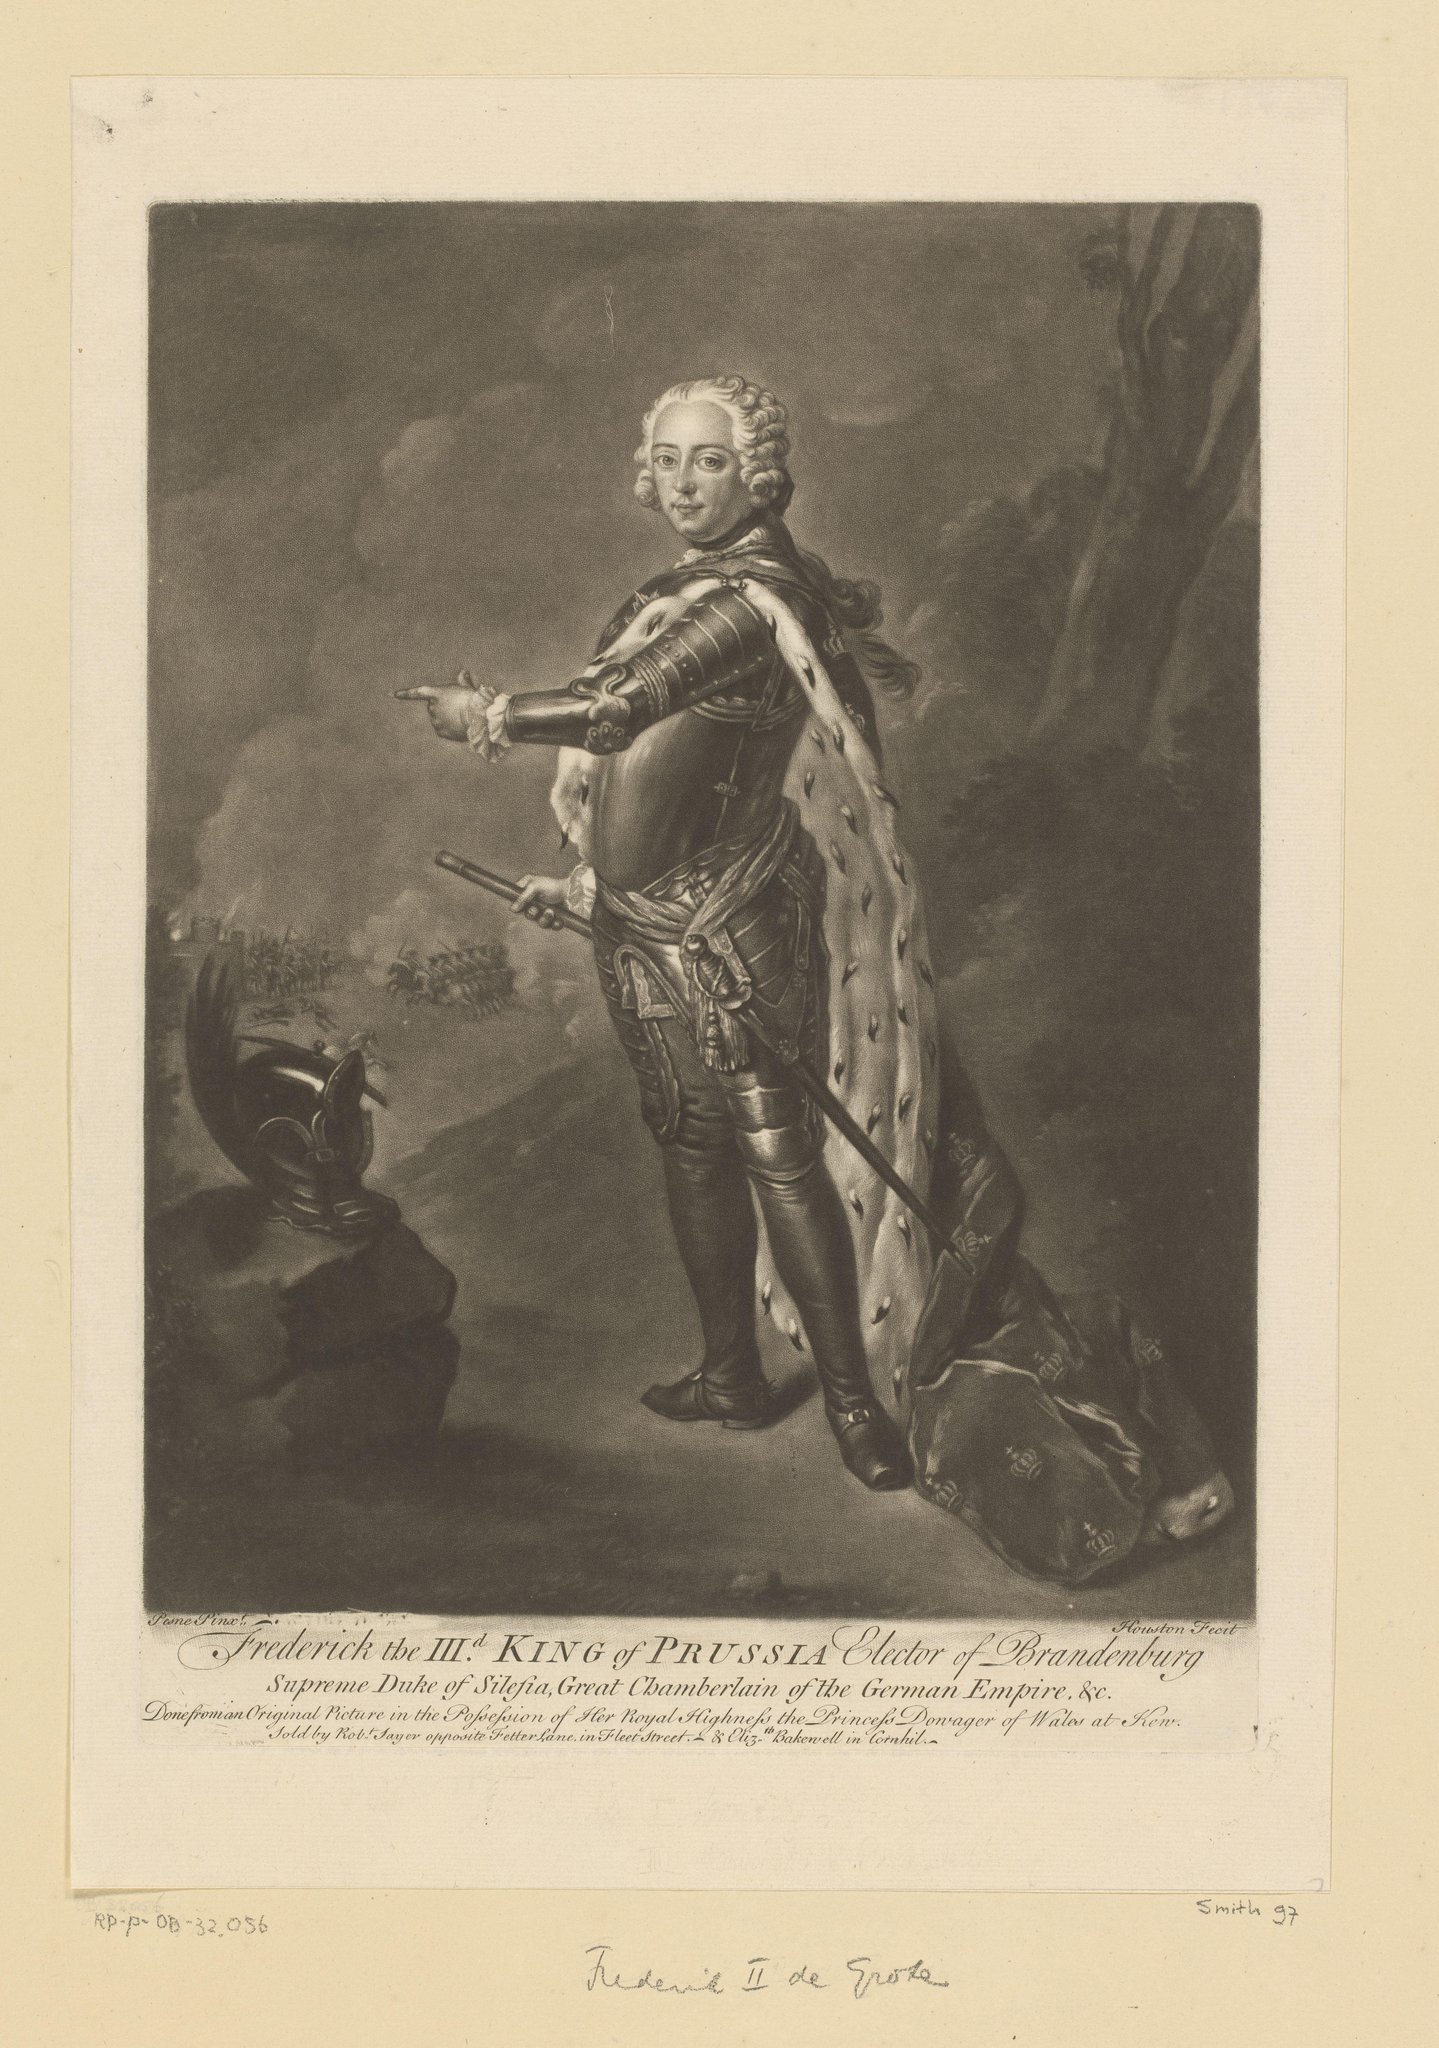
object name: print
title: Portret van Frederik de Grote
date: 1731-1775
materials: paper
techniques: etching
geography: london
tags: berlin, frederick ii (king of prussia), commander-in-chief, general, marshal, historical persons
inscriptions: collector's mark: Lugt 240